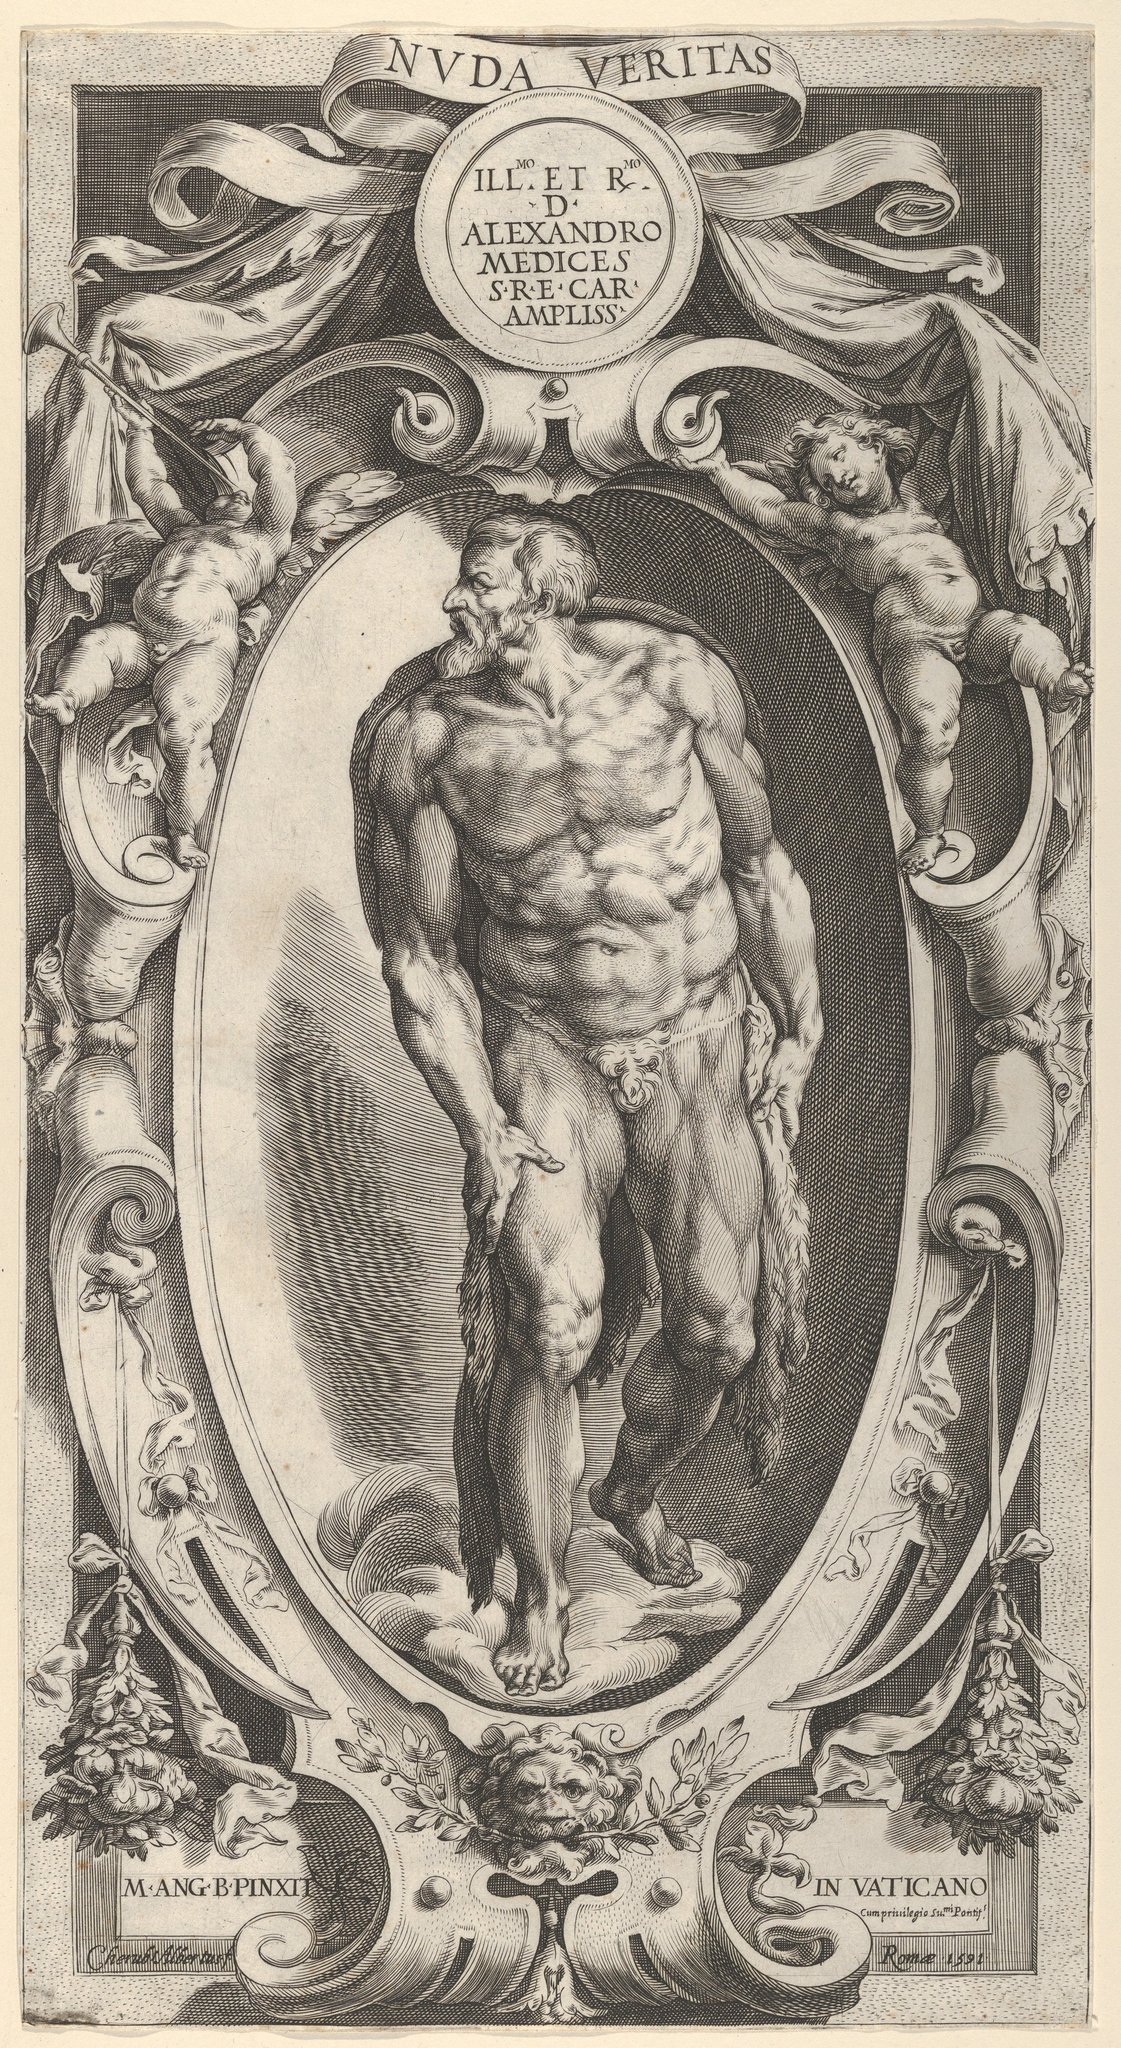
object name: print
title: Saint John the Baptist in a decorative border, after Michelangelo's 'The Last Judgment' fresco in the Sistine Chapel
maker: cherubino alberti (zaccaria mattia)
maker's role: artist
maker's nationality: italian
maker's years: 1553-1615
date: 1591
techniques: engraving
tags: putti,lions,saint john the baptist